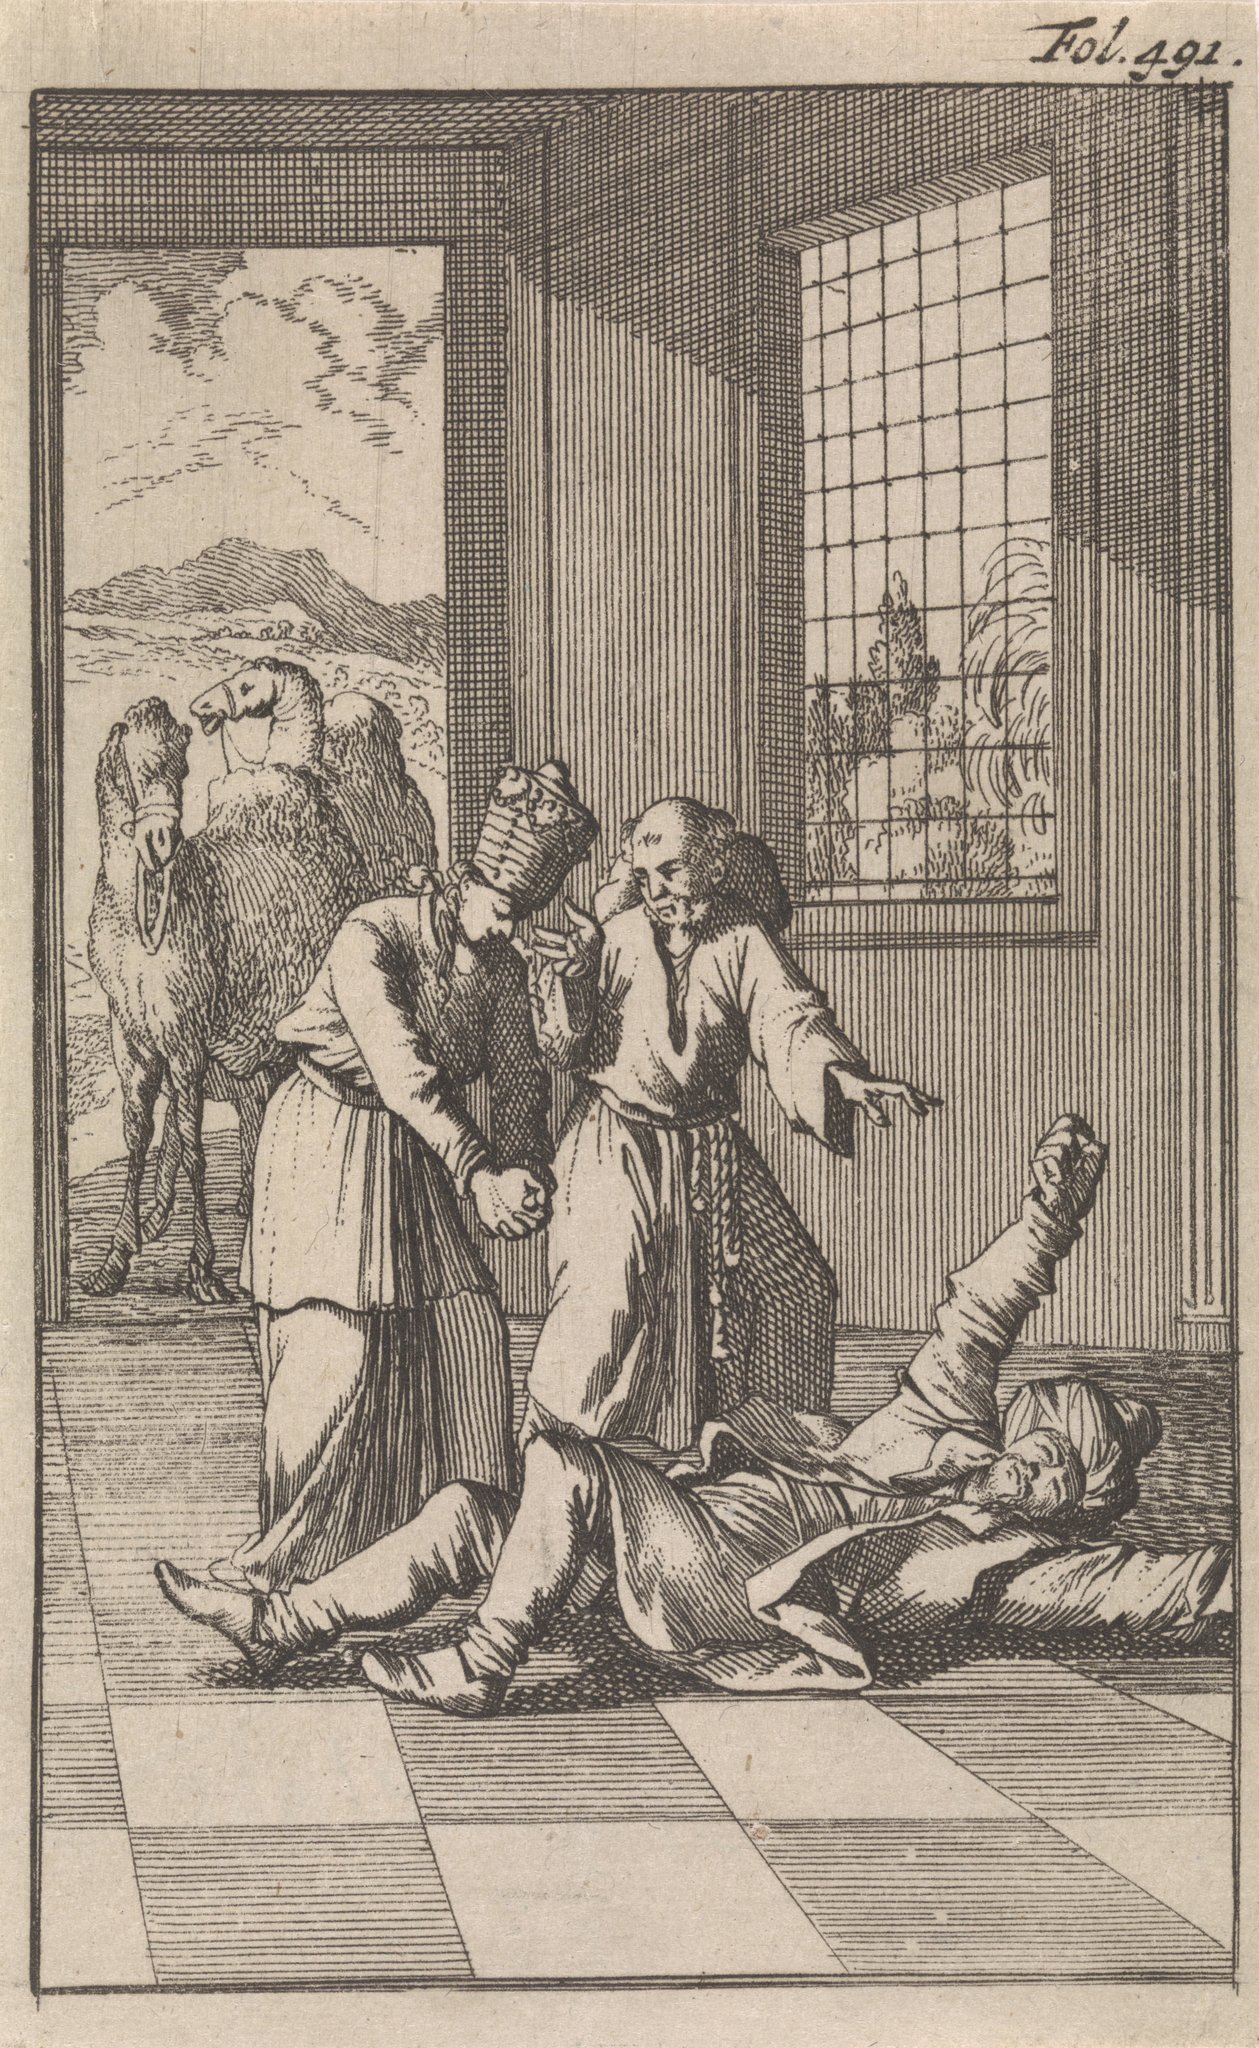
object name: book illustration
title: Mahomed valt in vervoering aan de voeten van zijn vrouw Kadiga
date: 1696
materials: paper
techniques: etching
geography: amsterdam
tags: hoofed animals: camel, asiatic races and peoples: turks, fainting, swooning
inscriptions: collector's mark: Lugt 2228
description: Illustratie uit: Ryer, André du. Mahomets Alkoran. [vertaald uit het Frans door] Jan Hendrik Glazemaker. Amsterdam: Timotheus ten Hoorn, 1696.